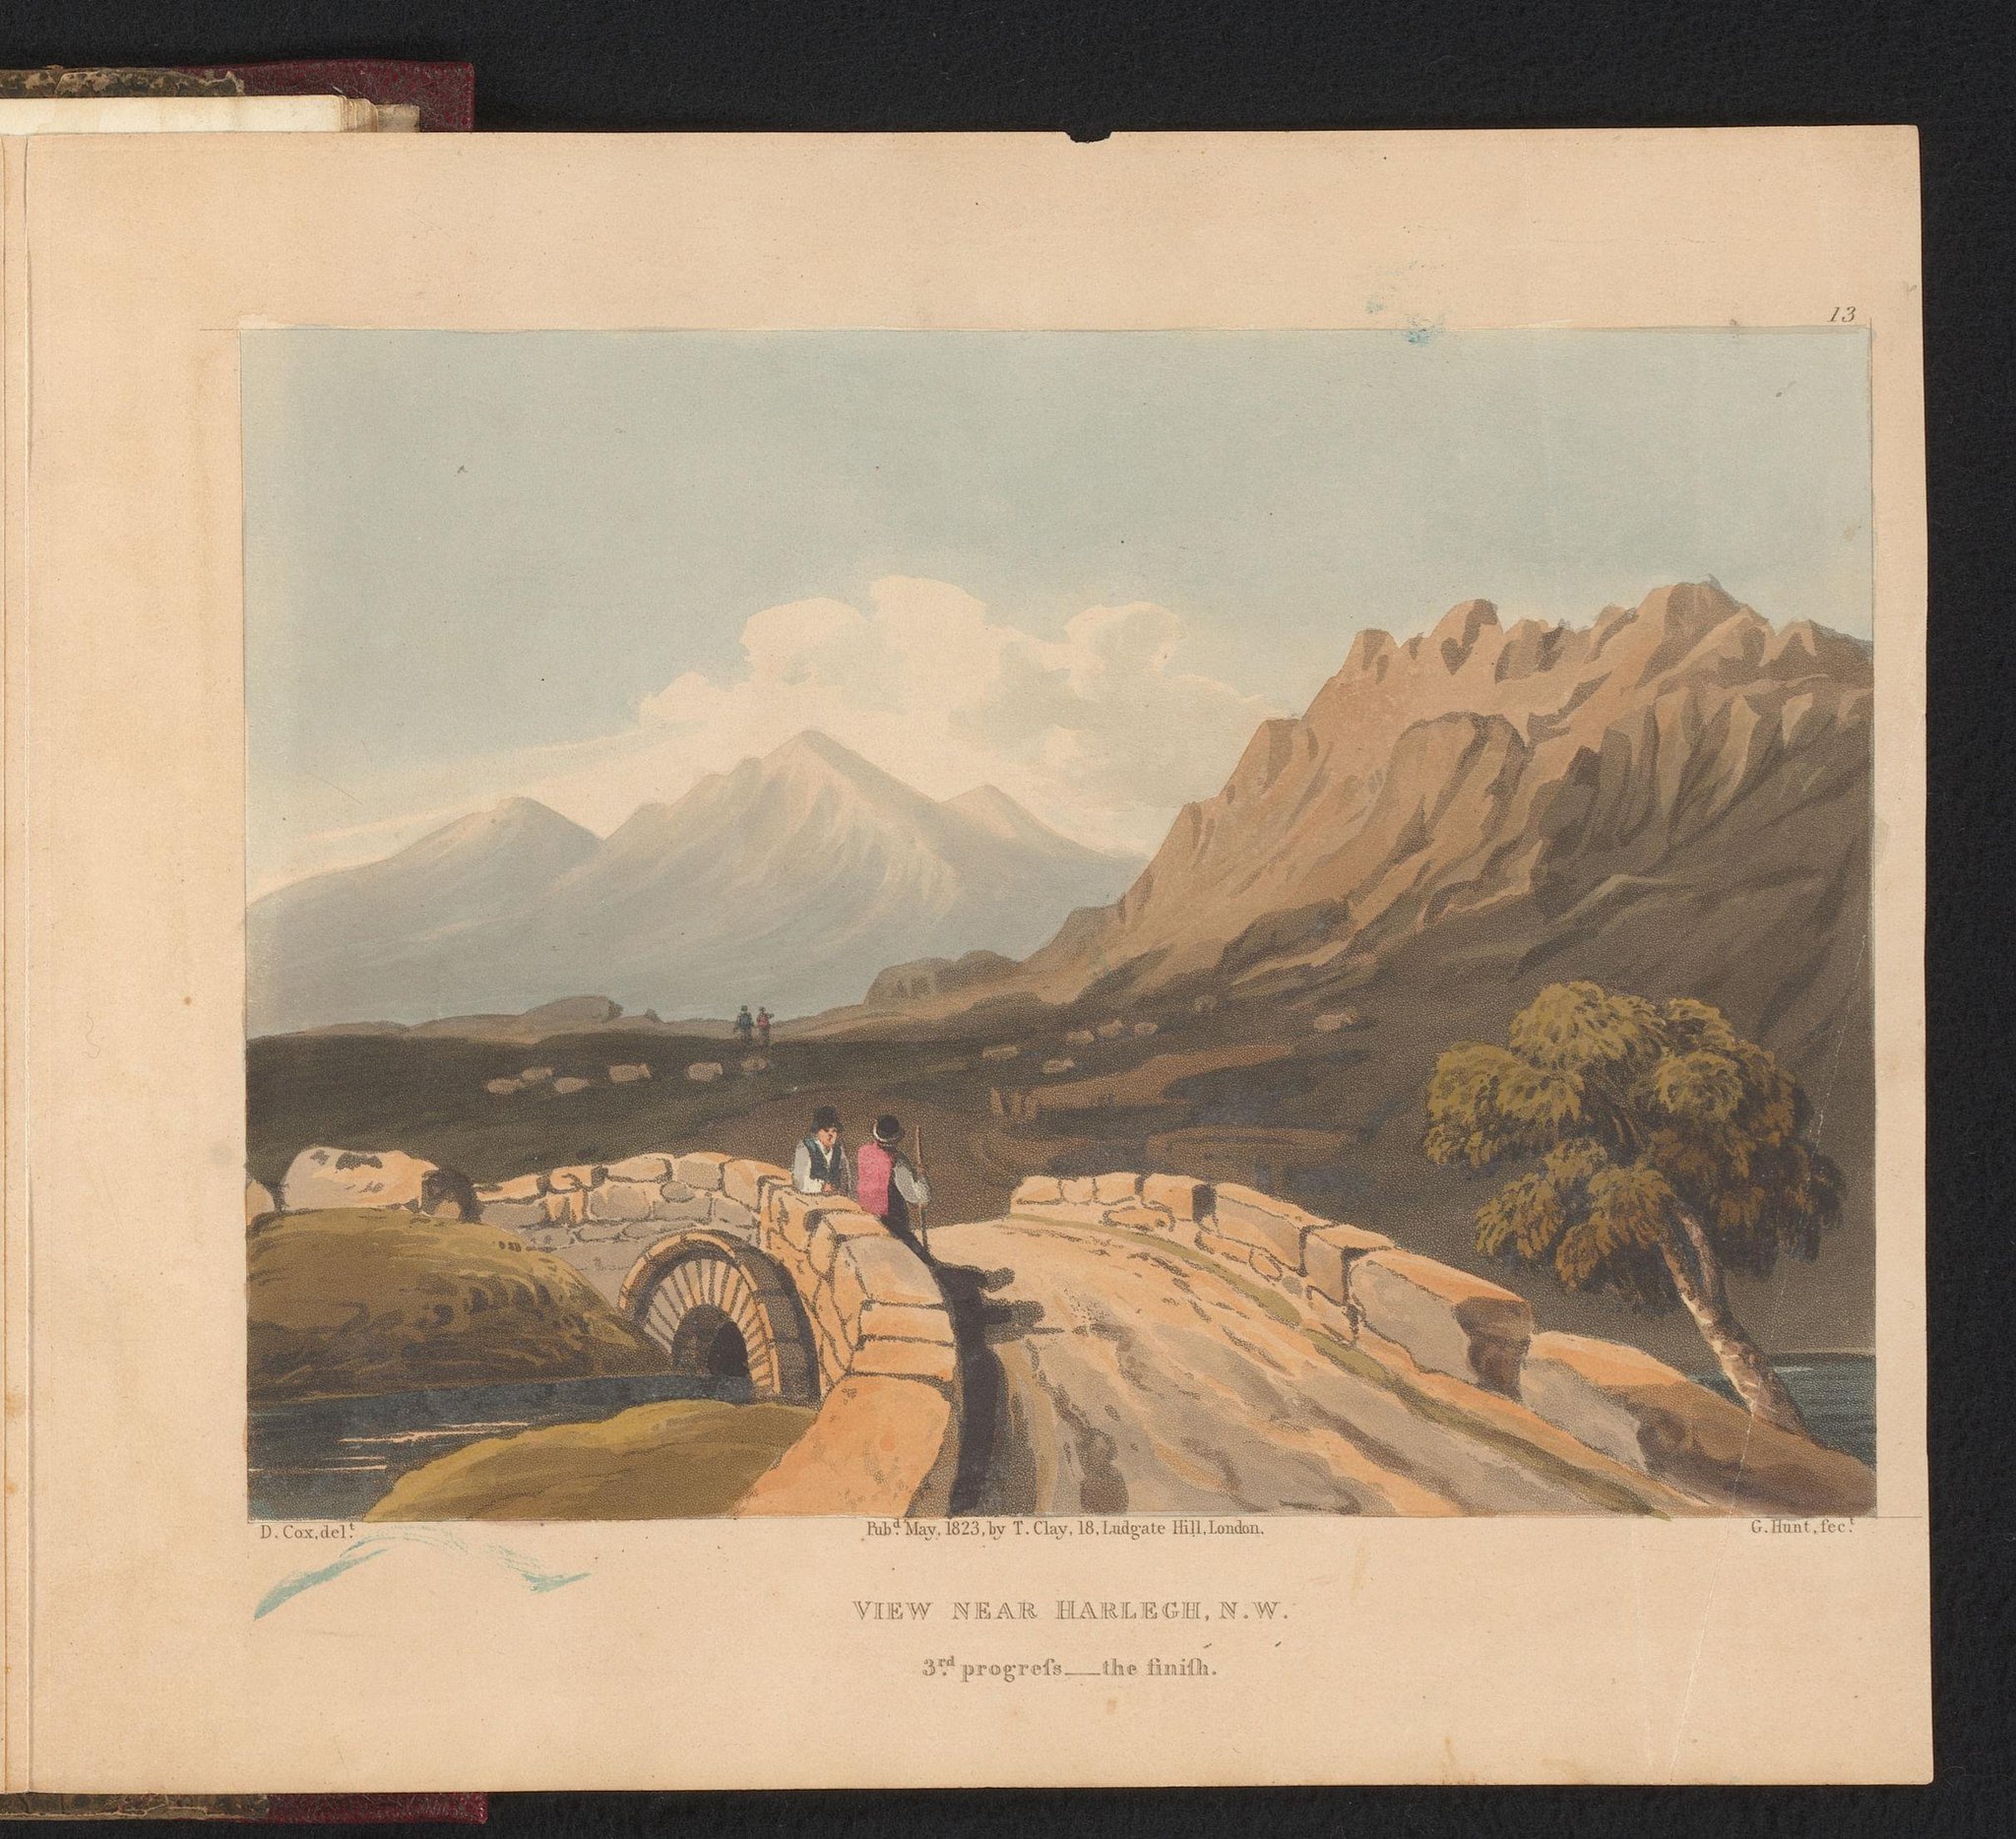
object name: print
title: 2nd progress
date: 1828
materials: paper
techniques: aquatint, hand coloring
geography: london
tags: painting (including book-illumination, miniature-painting), bridge, river (+ landscape with figures, staffage)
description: Prent zit tussen pagina 22 en 23 en is vastgeplakt aan vier prenten die als serie uit te vouwen zijn.